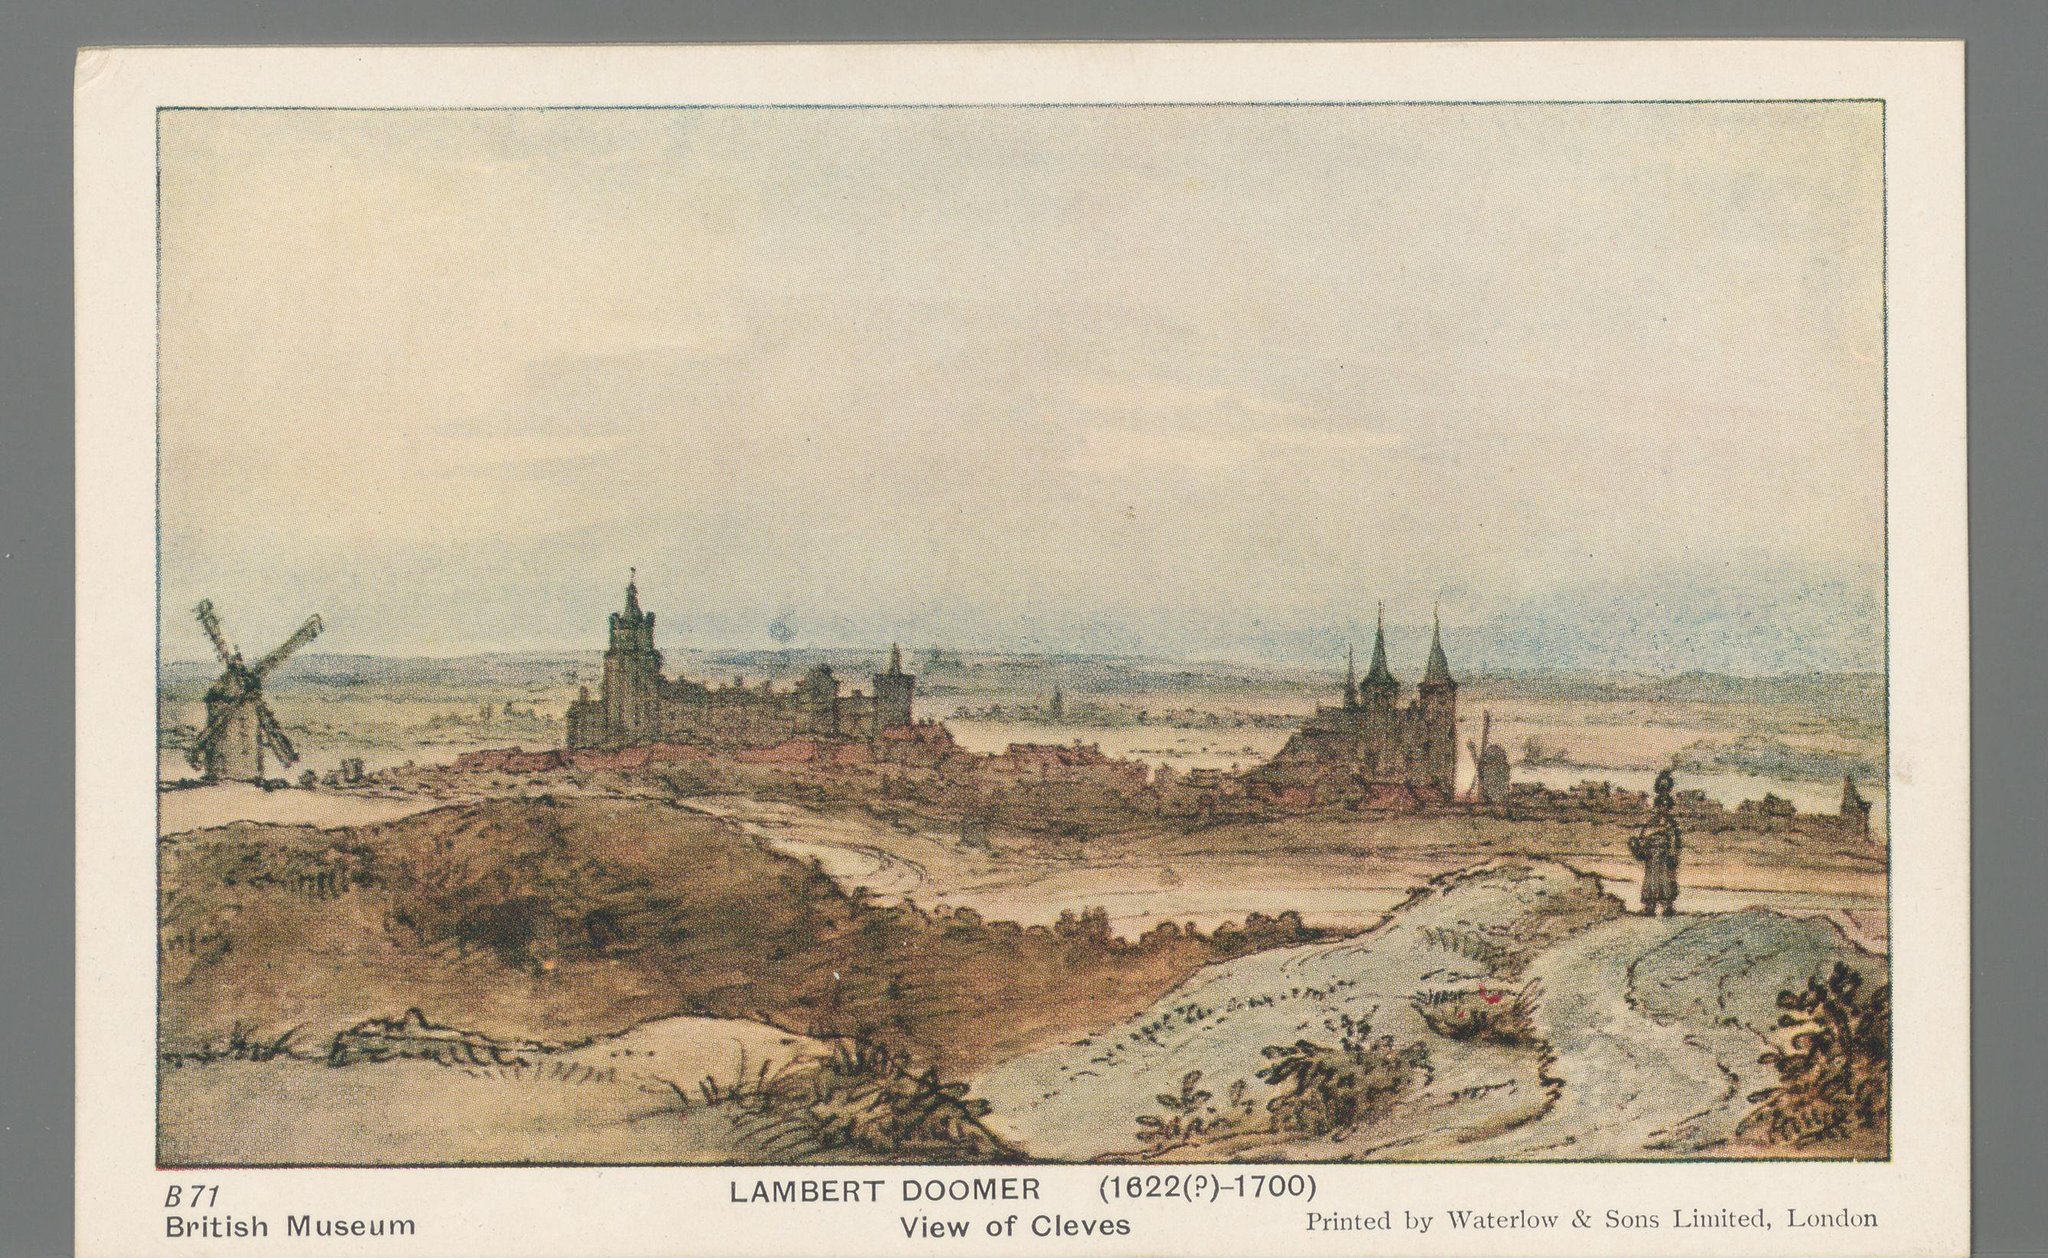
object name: photomechanical print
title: Lambert Doomer (1622(?) - 1700). View of Cleves. British Museum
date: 1902-1930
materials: cardboard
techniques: color autotype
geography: london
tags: permanent exhibition, museum, picture, painting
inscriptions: collector's mark: ‘AFE v S’